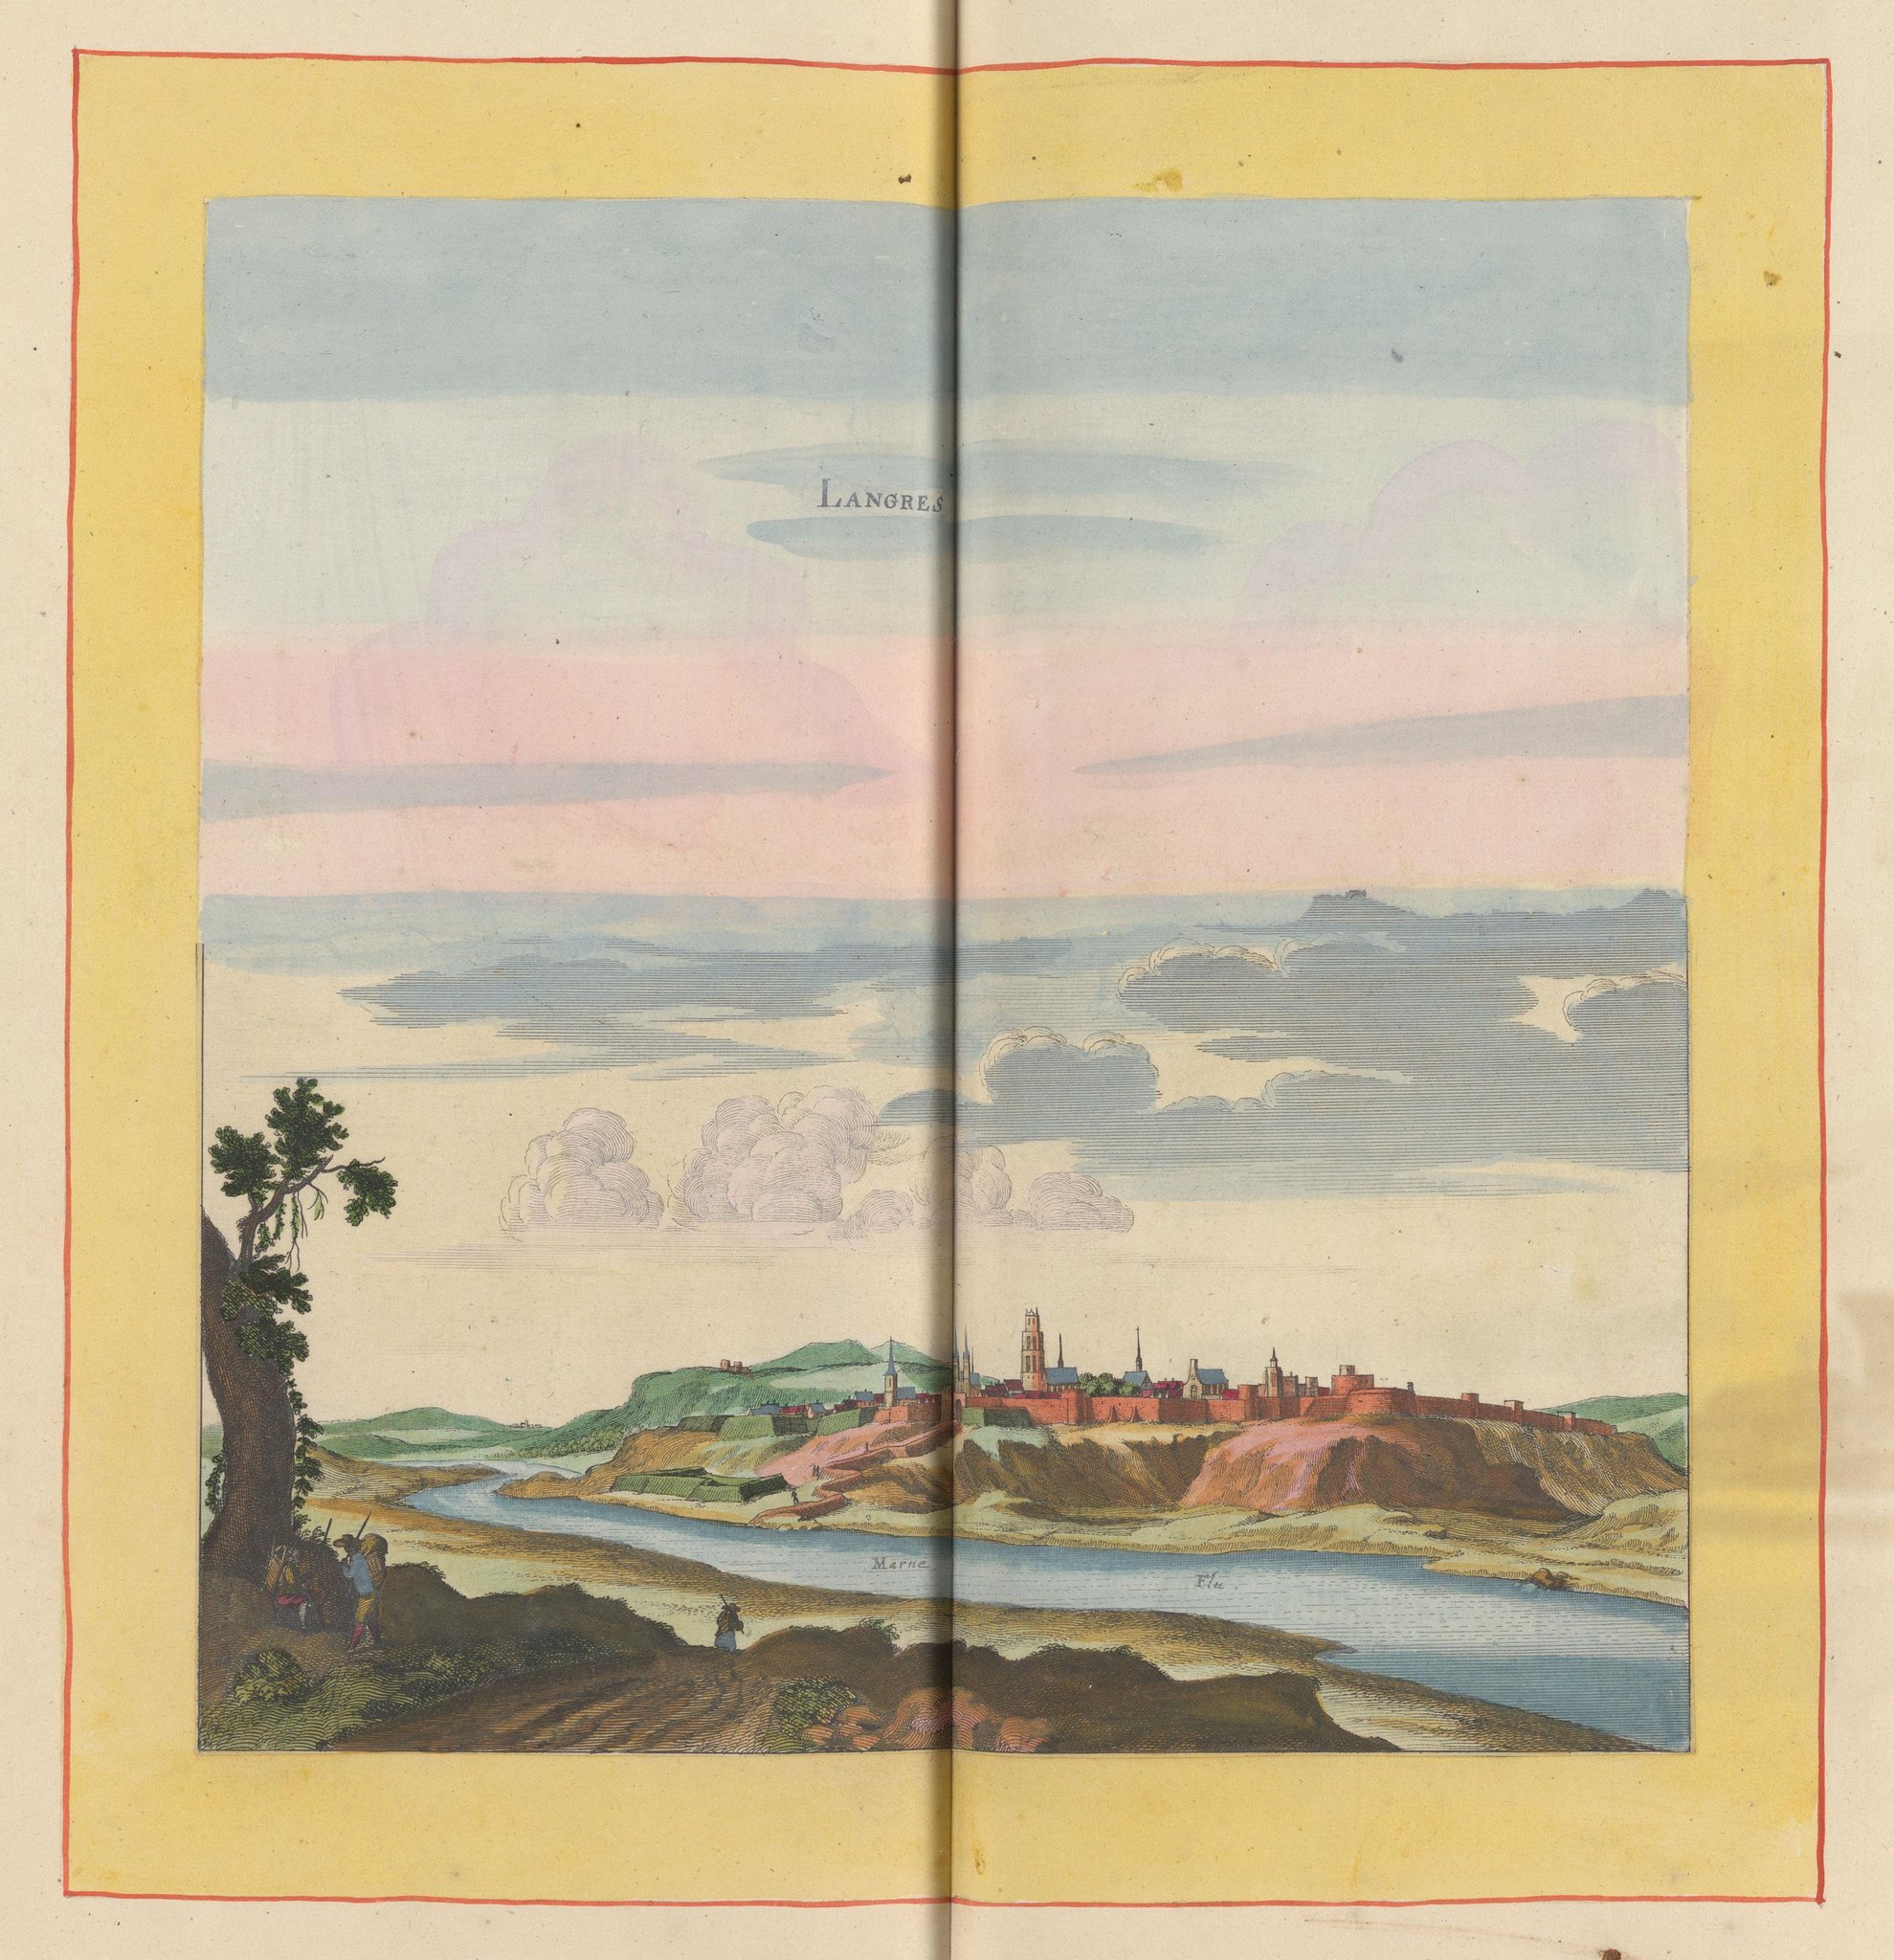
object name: album leaf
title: Gezicht op Langres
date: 1656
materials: paper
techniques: engraving, etching, hand coloring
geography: frankfurt am main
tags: city-view in general; 'veduta'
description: Prent uit: Zeiller, Martin. Topographia Galliae. 13 dln. Frankfurt: Caspar Merian, 1656, dl. 3, na p. 14.